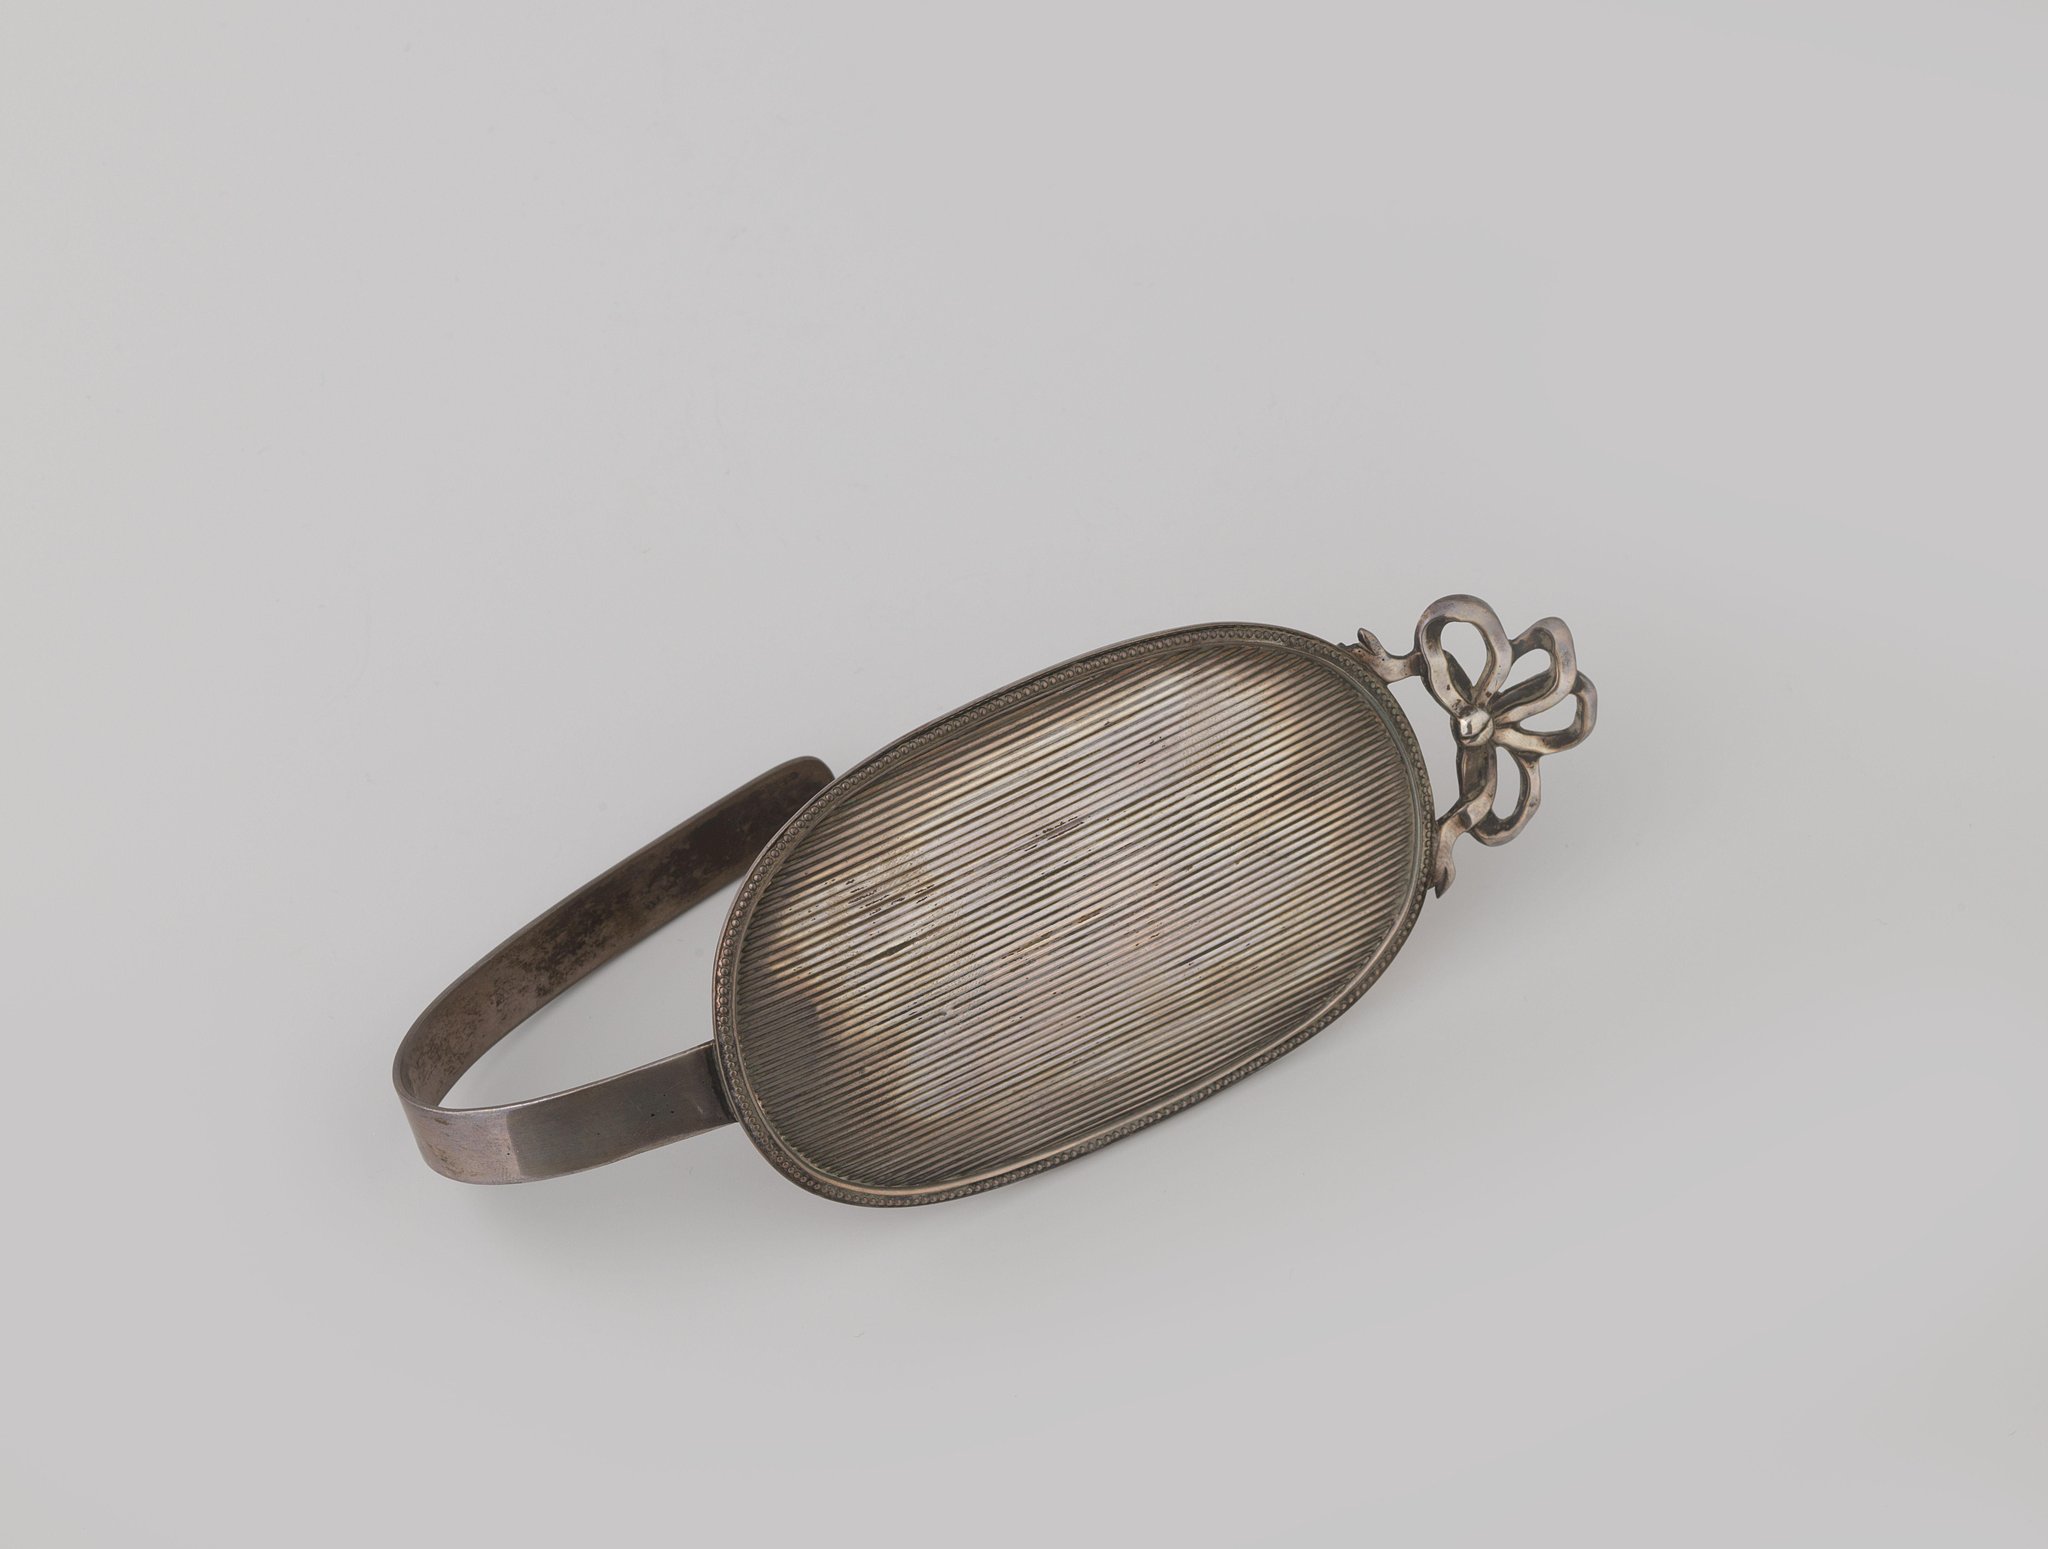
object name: curtain hook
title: Gordijnhaak van zilver met ovaal schild met parelrand en strik.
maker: Anonymous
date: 1800-1850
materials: silver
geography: netherlands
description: Gordijnhaak van zilver. Met ovaal schild met parelrandje en aan het uiteinde een strikje. Meesterteken: H.S. onder ster.